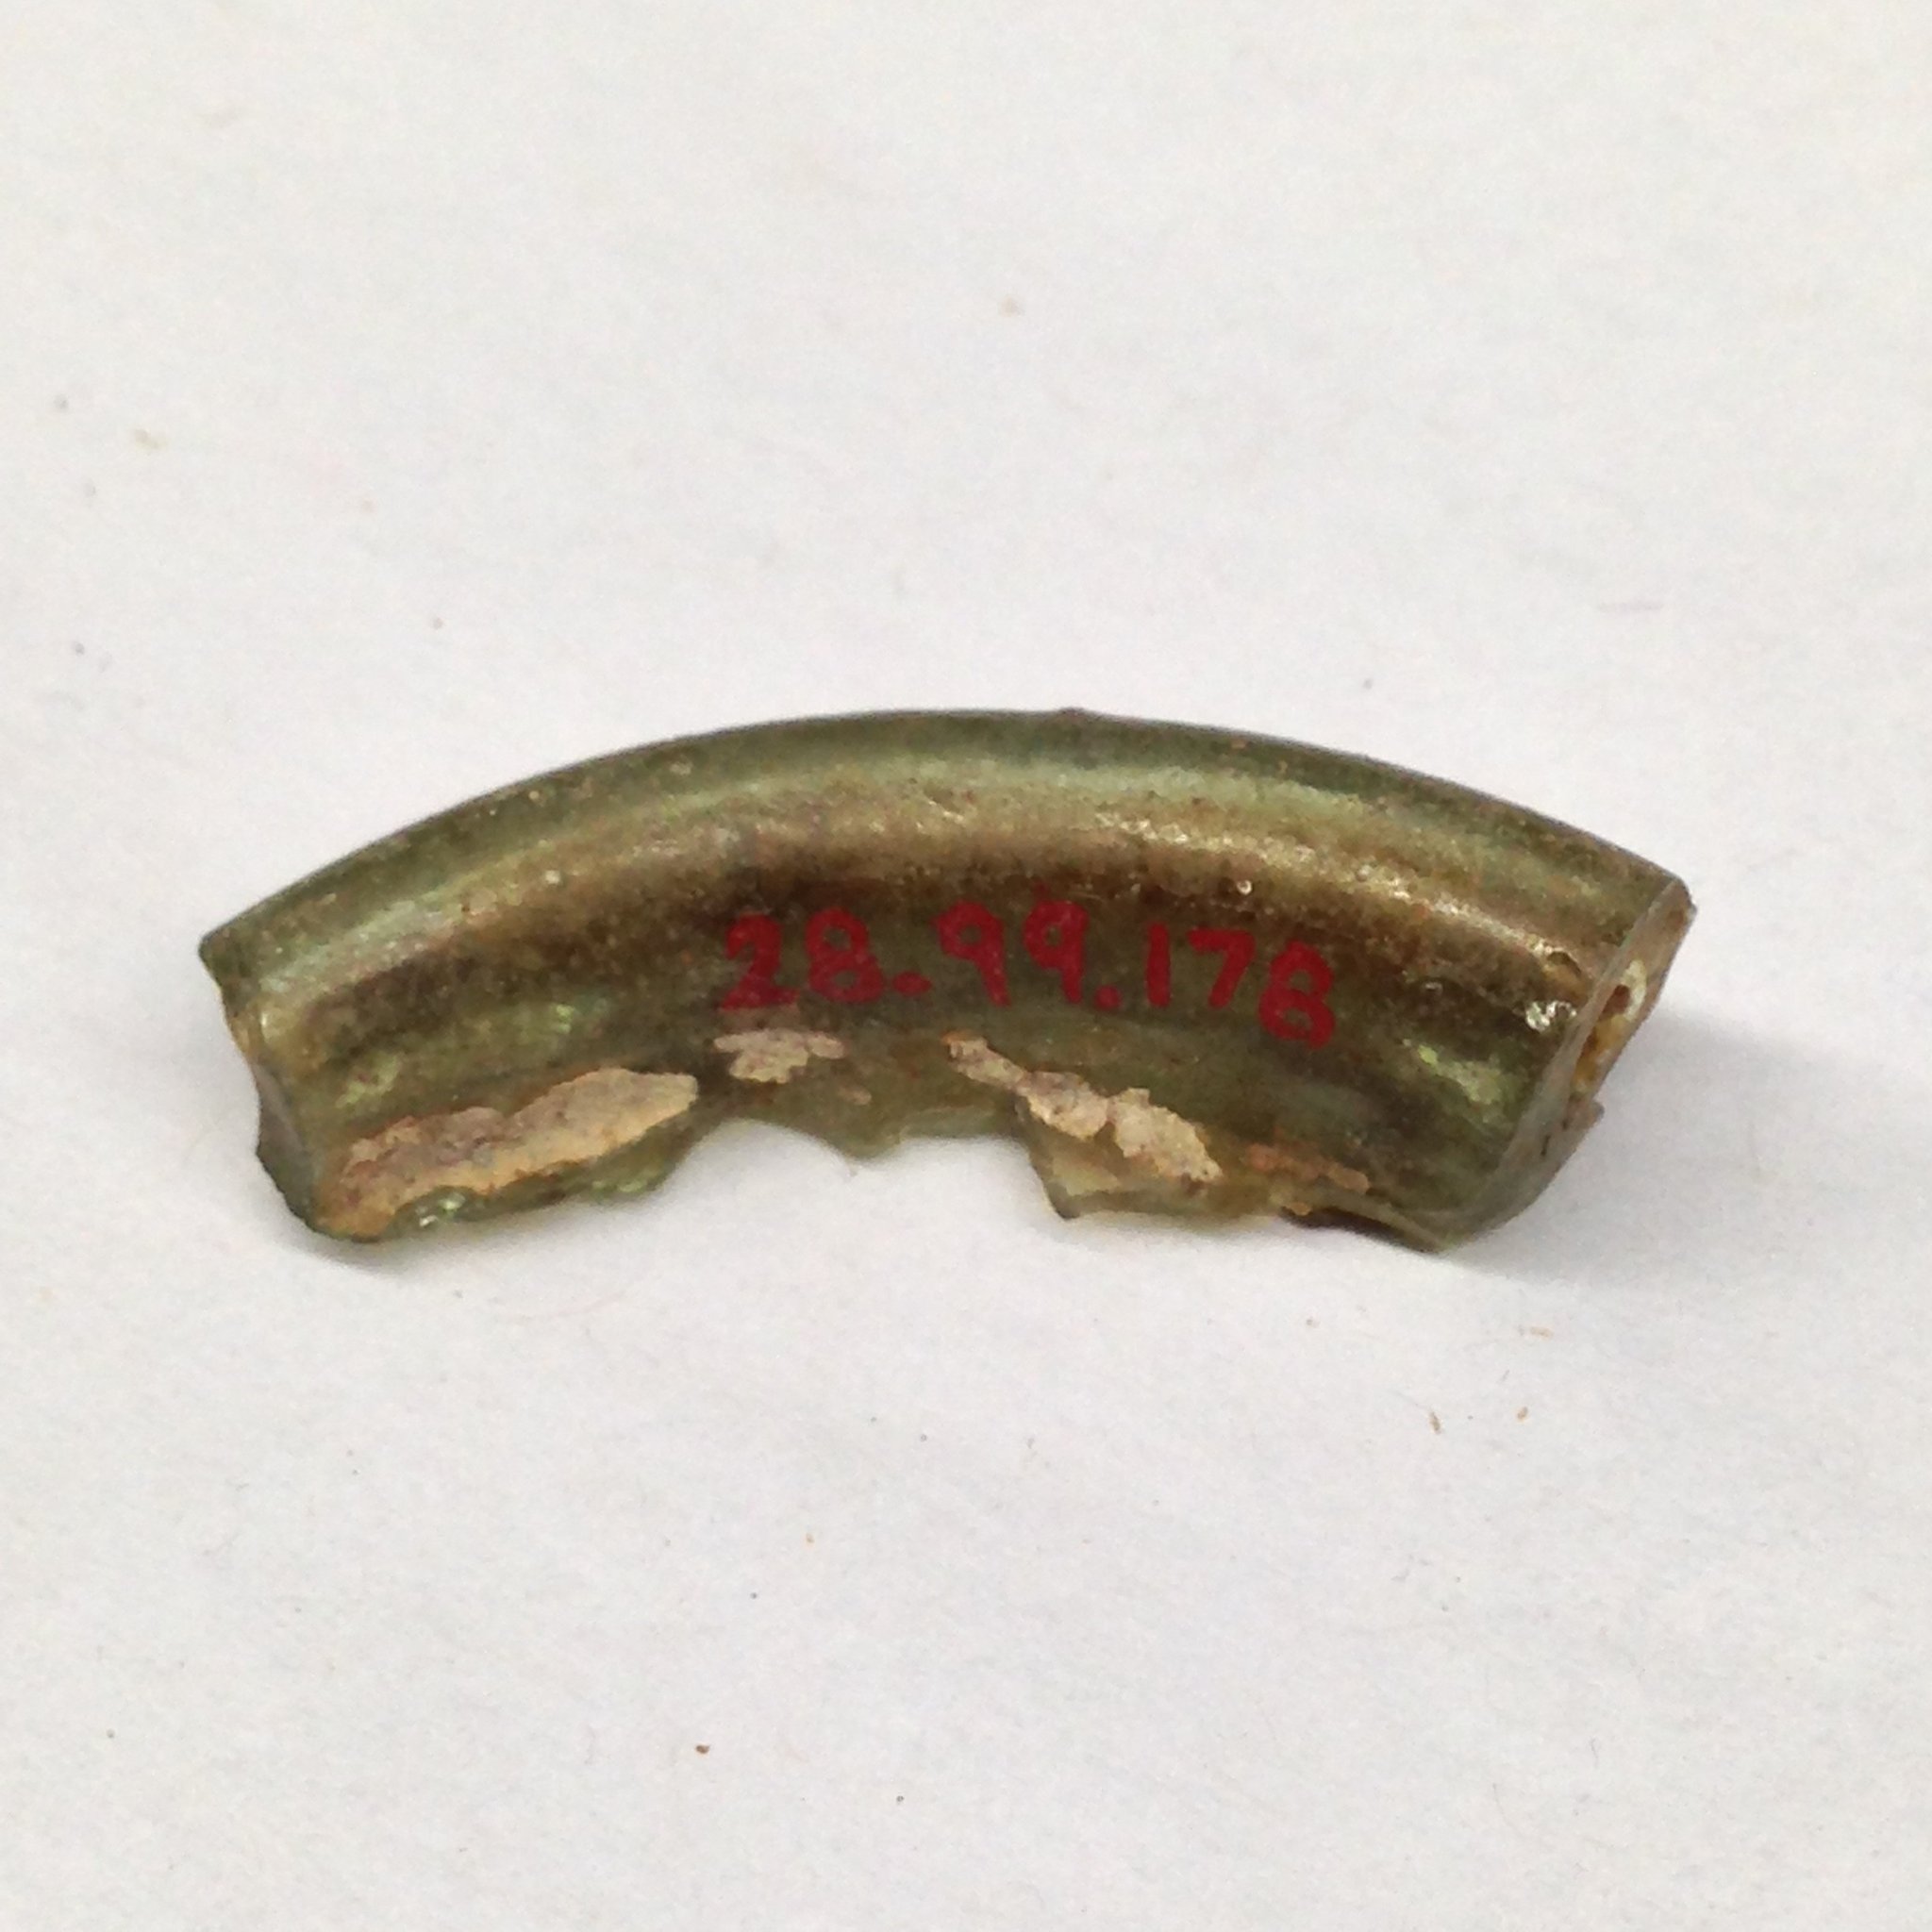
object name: fragment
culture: european or middle eastern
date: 1150-1250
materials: ceramic, glass